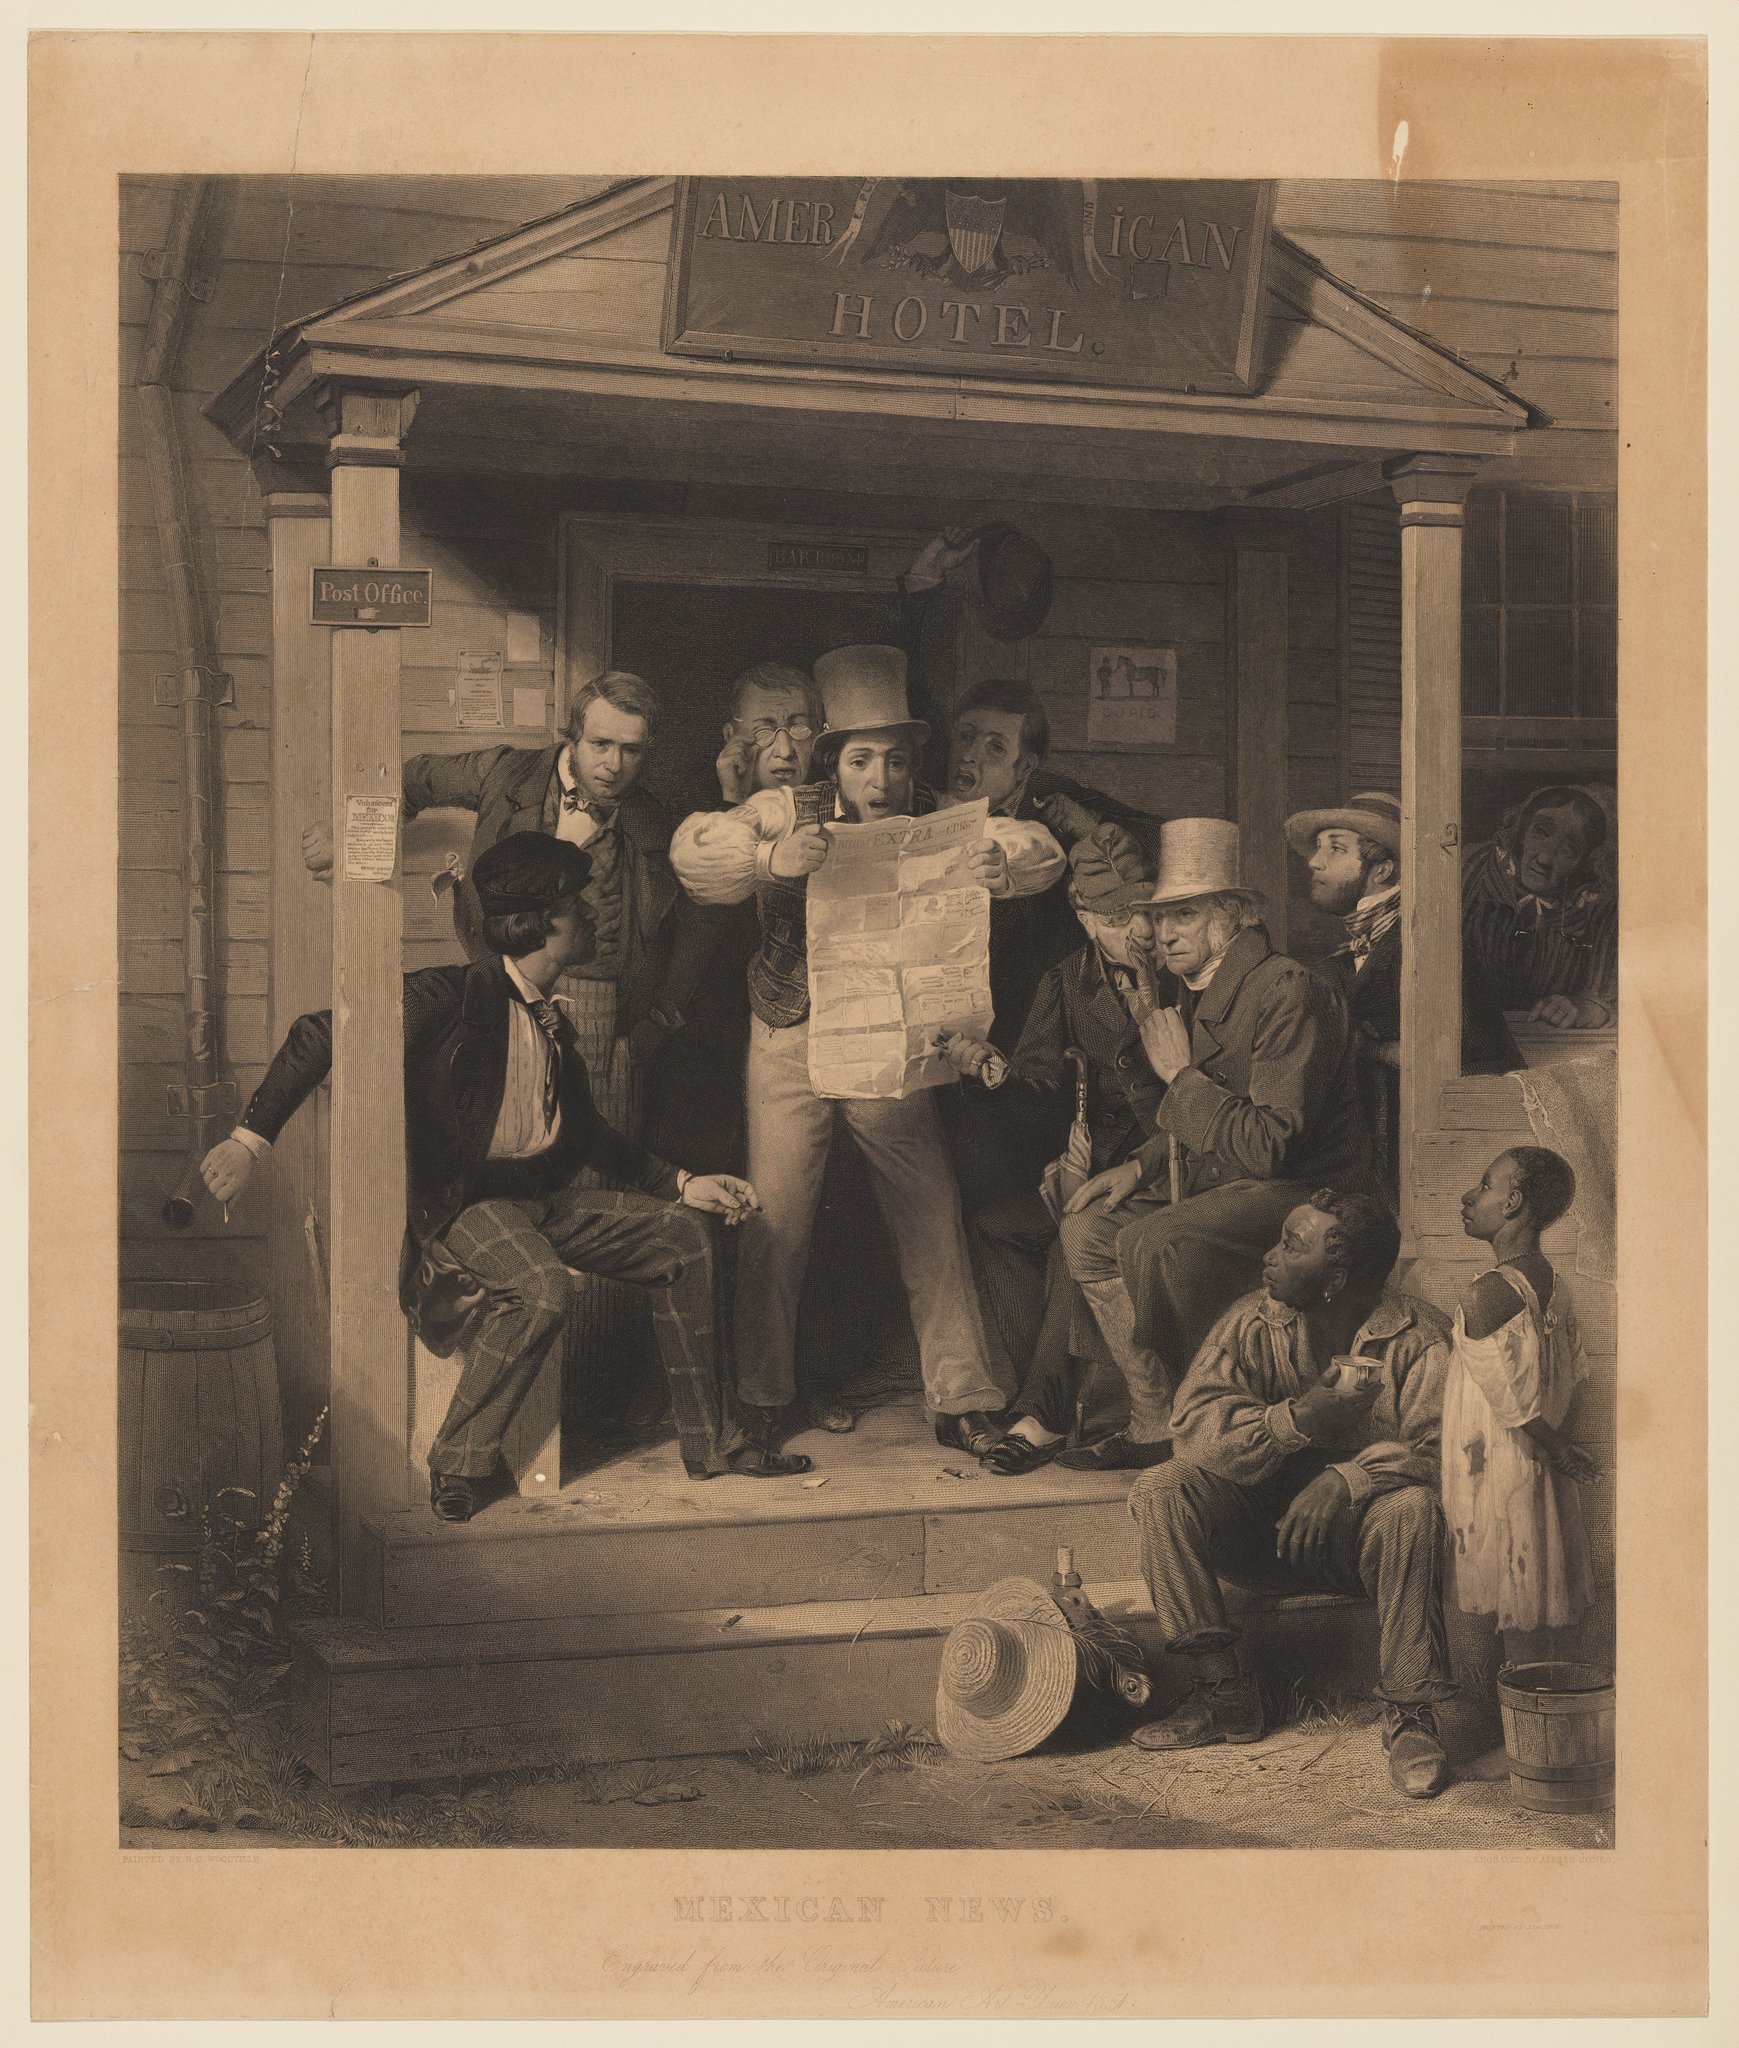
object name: print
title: Mexican News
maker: alfred jones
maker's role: engraver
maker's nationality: american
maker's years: 1819-1900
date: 1851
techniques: engraving, etching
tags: men,reading,newspapers